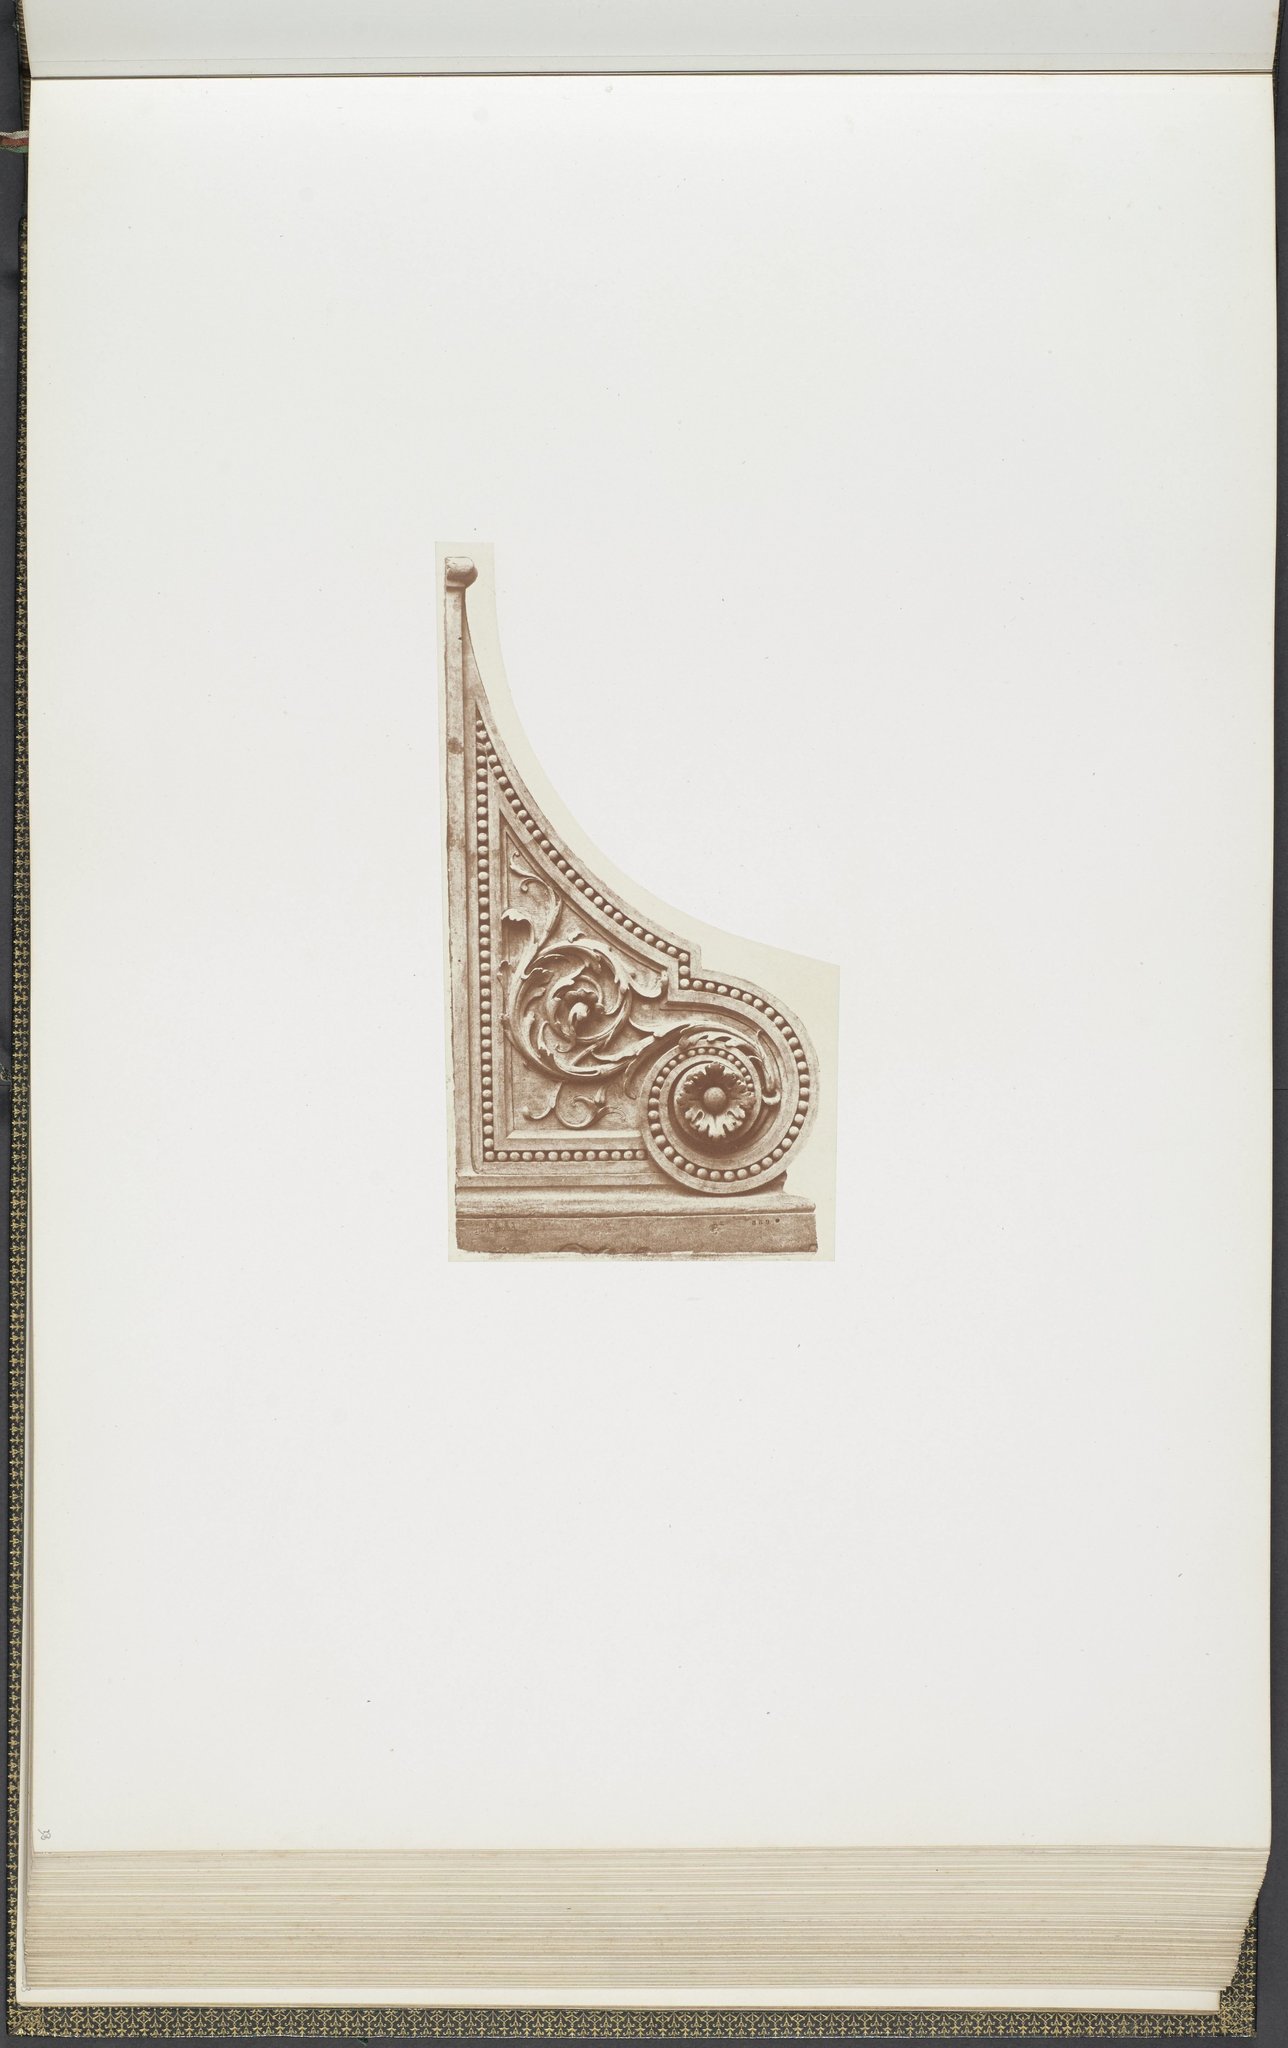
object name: album leaf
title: Detail van een gipsmodel voor de versiering van de tweede verdieping van het Pavillon de Turgot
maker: édouard denis baldus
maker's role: fotograaf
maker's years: 1813-1889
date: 1855-1857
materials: paper, photographic support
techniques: salted paper print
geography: paris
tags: permanent exhibition, museum, ornamenting, decorating ~ applied arts, paris, tuileries palace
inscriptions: number: ‘889’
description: Onderdeel van Réunion des Tuileries au Louvre 1852-1857, album 1.